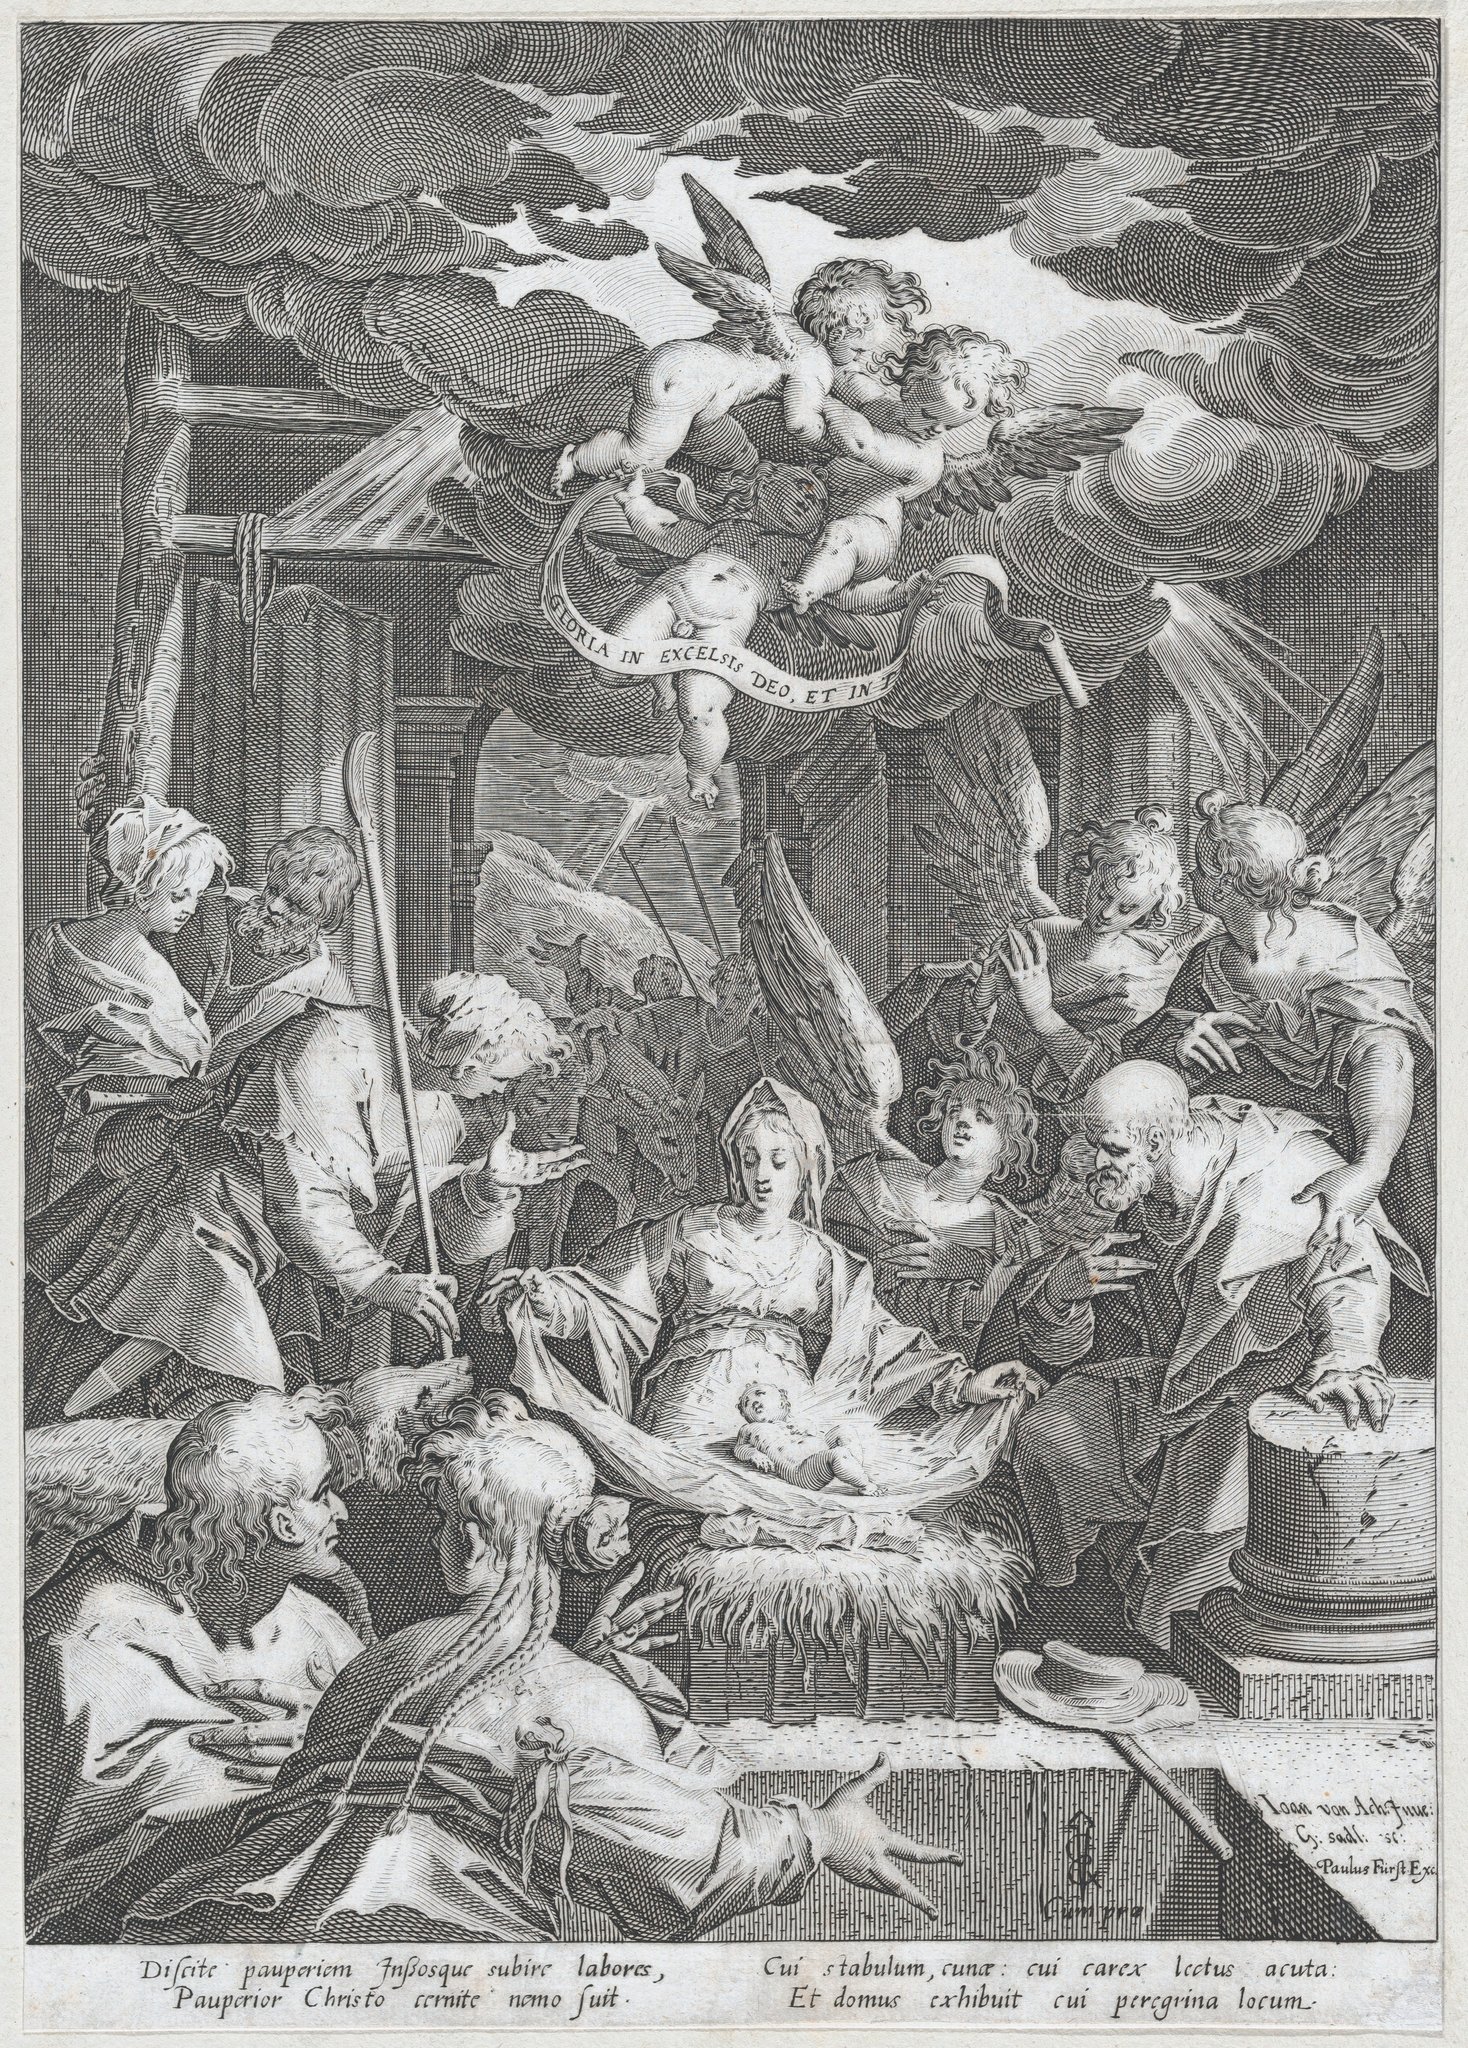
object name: print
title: Nativity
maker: aegidius sadeler (ii)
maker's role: artist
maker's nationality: flemish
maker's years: 1568-1629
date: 1588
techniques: engraving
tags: virgin mary,jesus,nativity